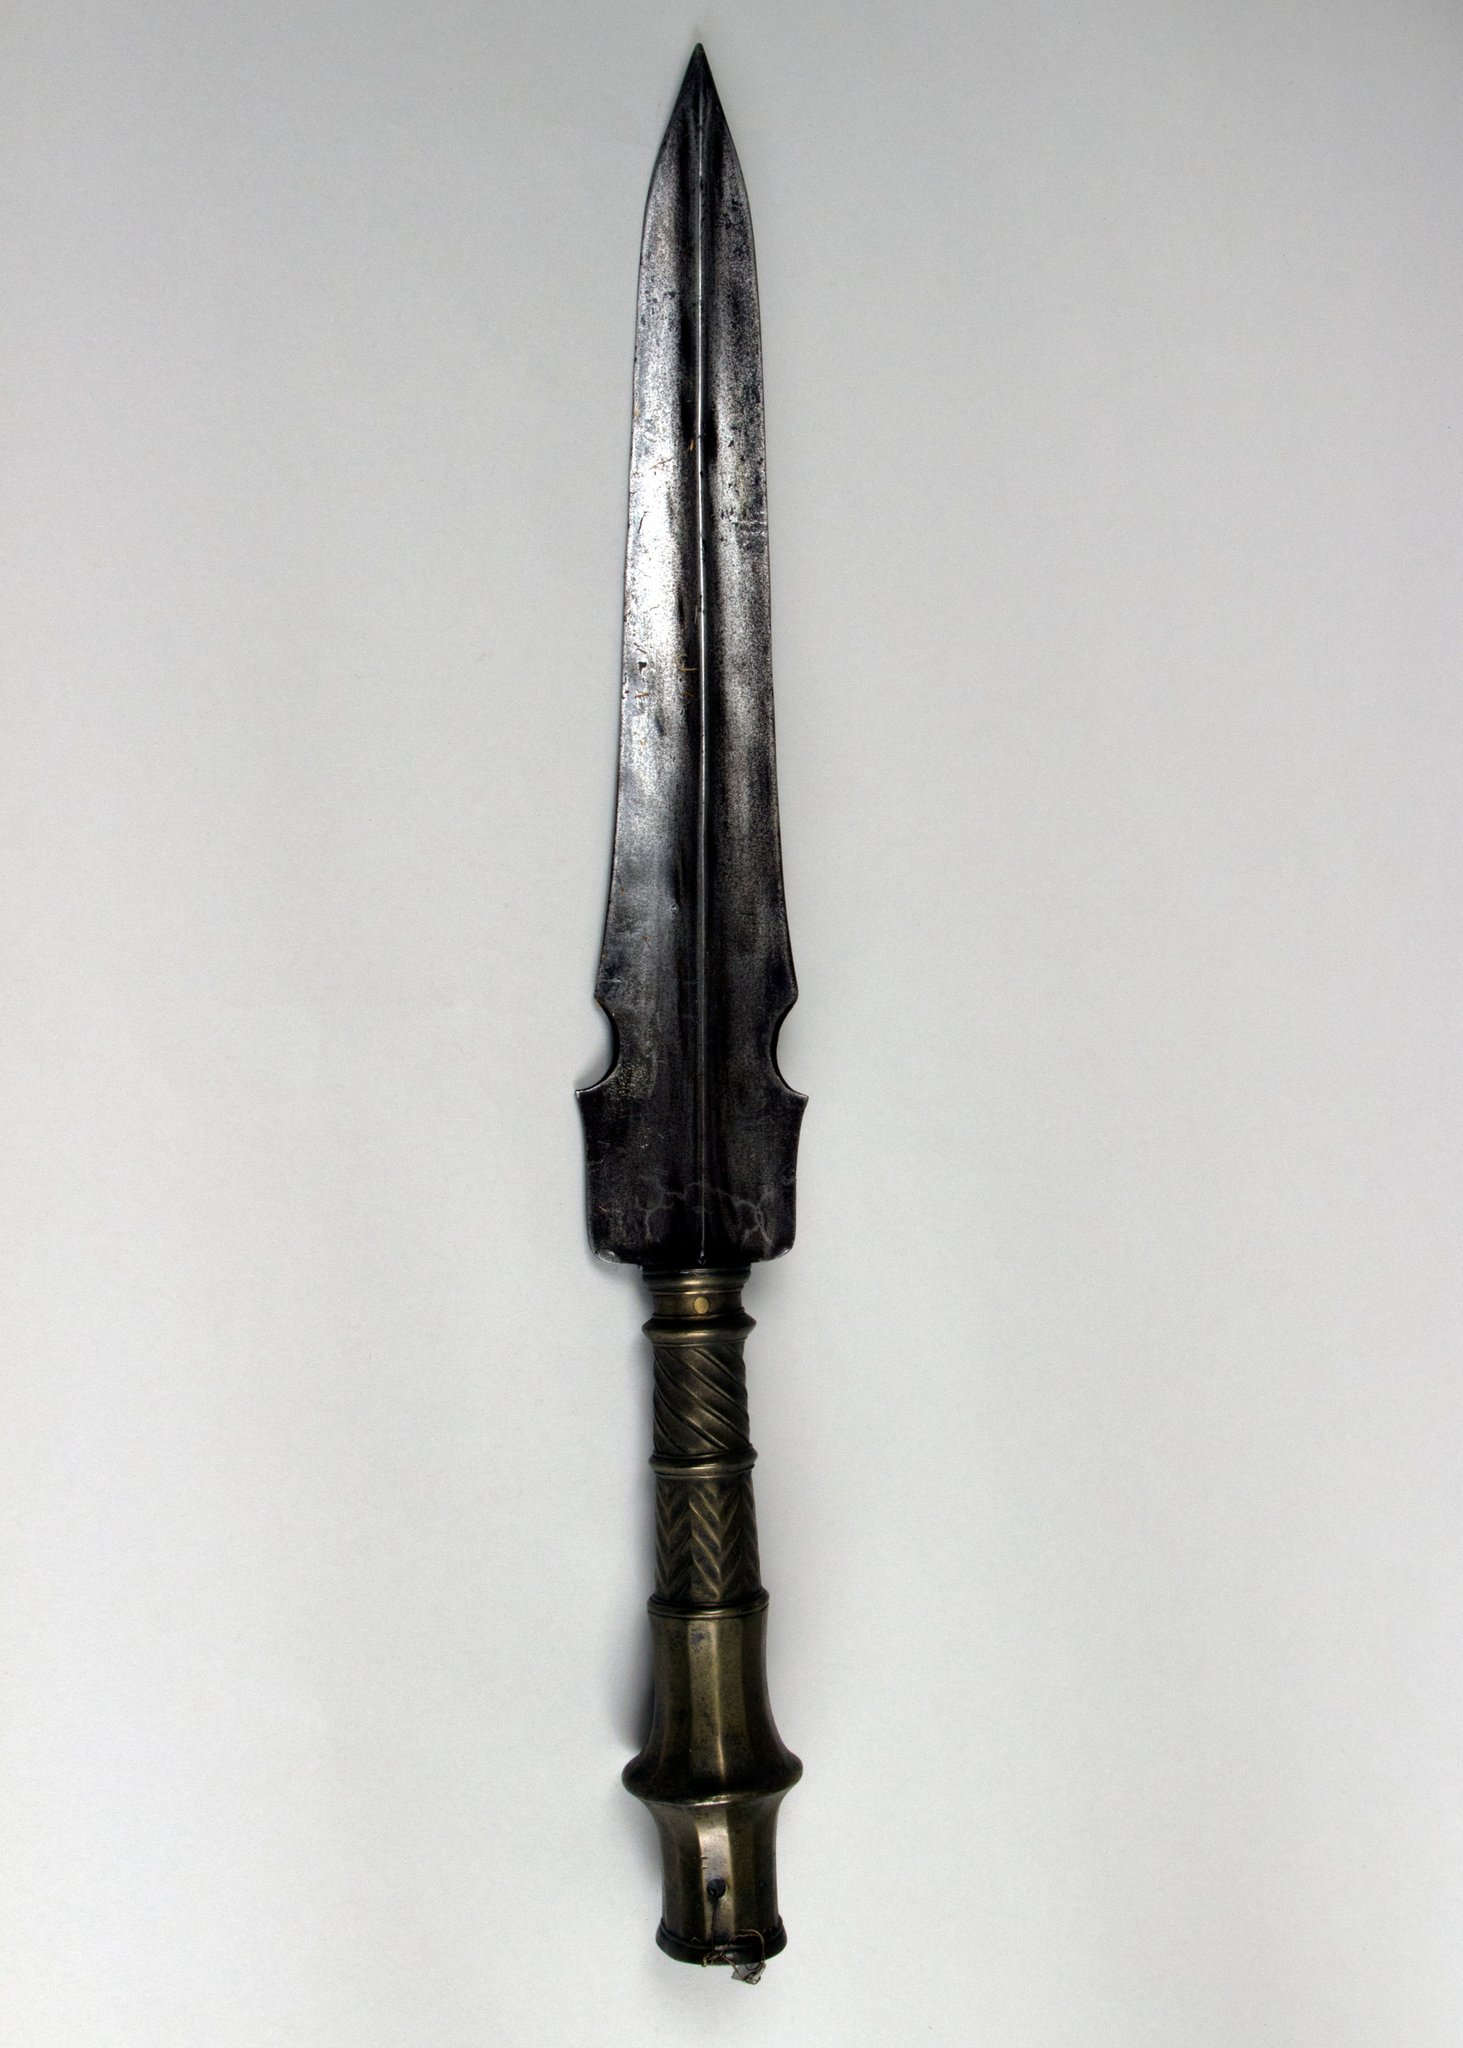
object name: processional spearhead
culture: sri lankan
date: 1701-1900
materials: steel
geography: sri lanka